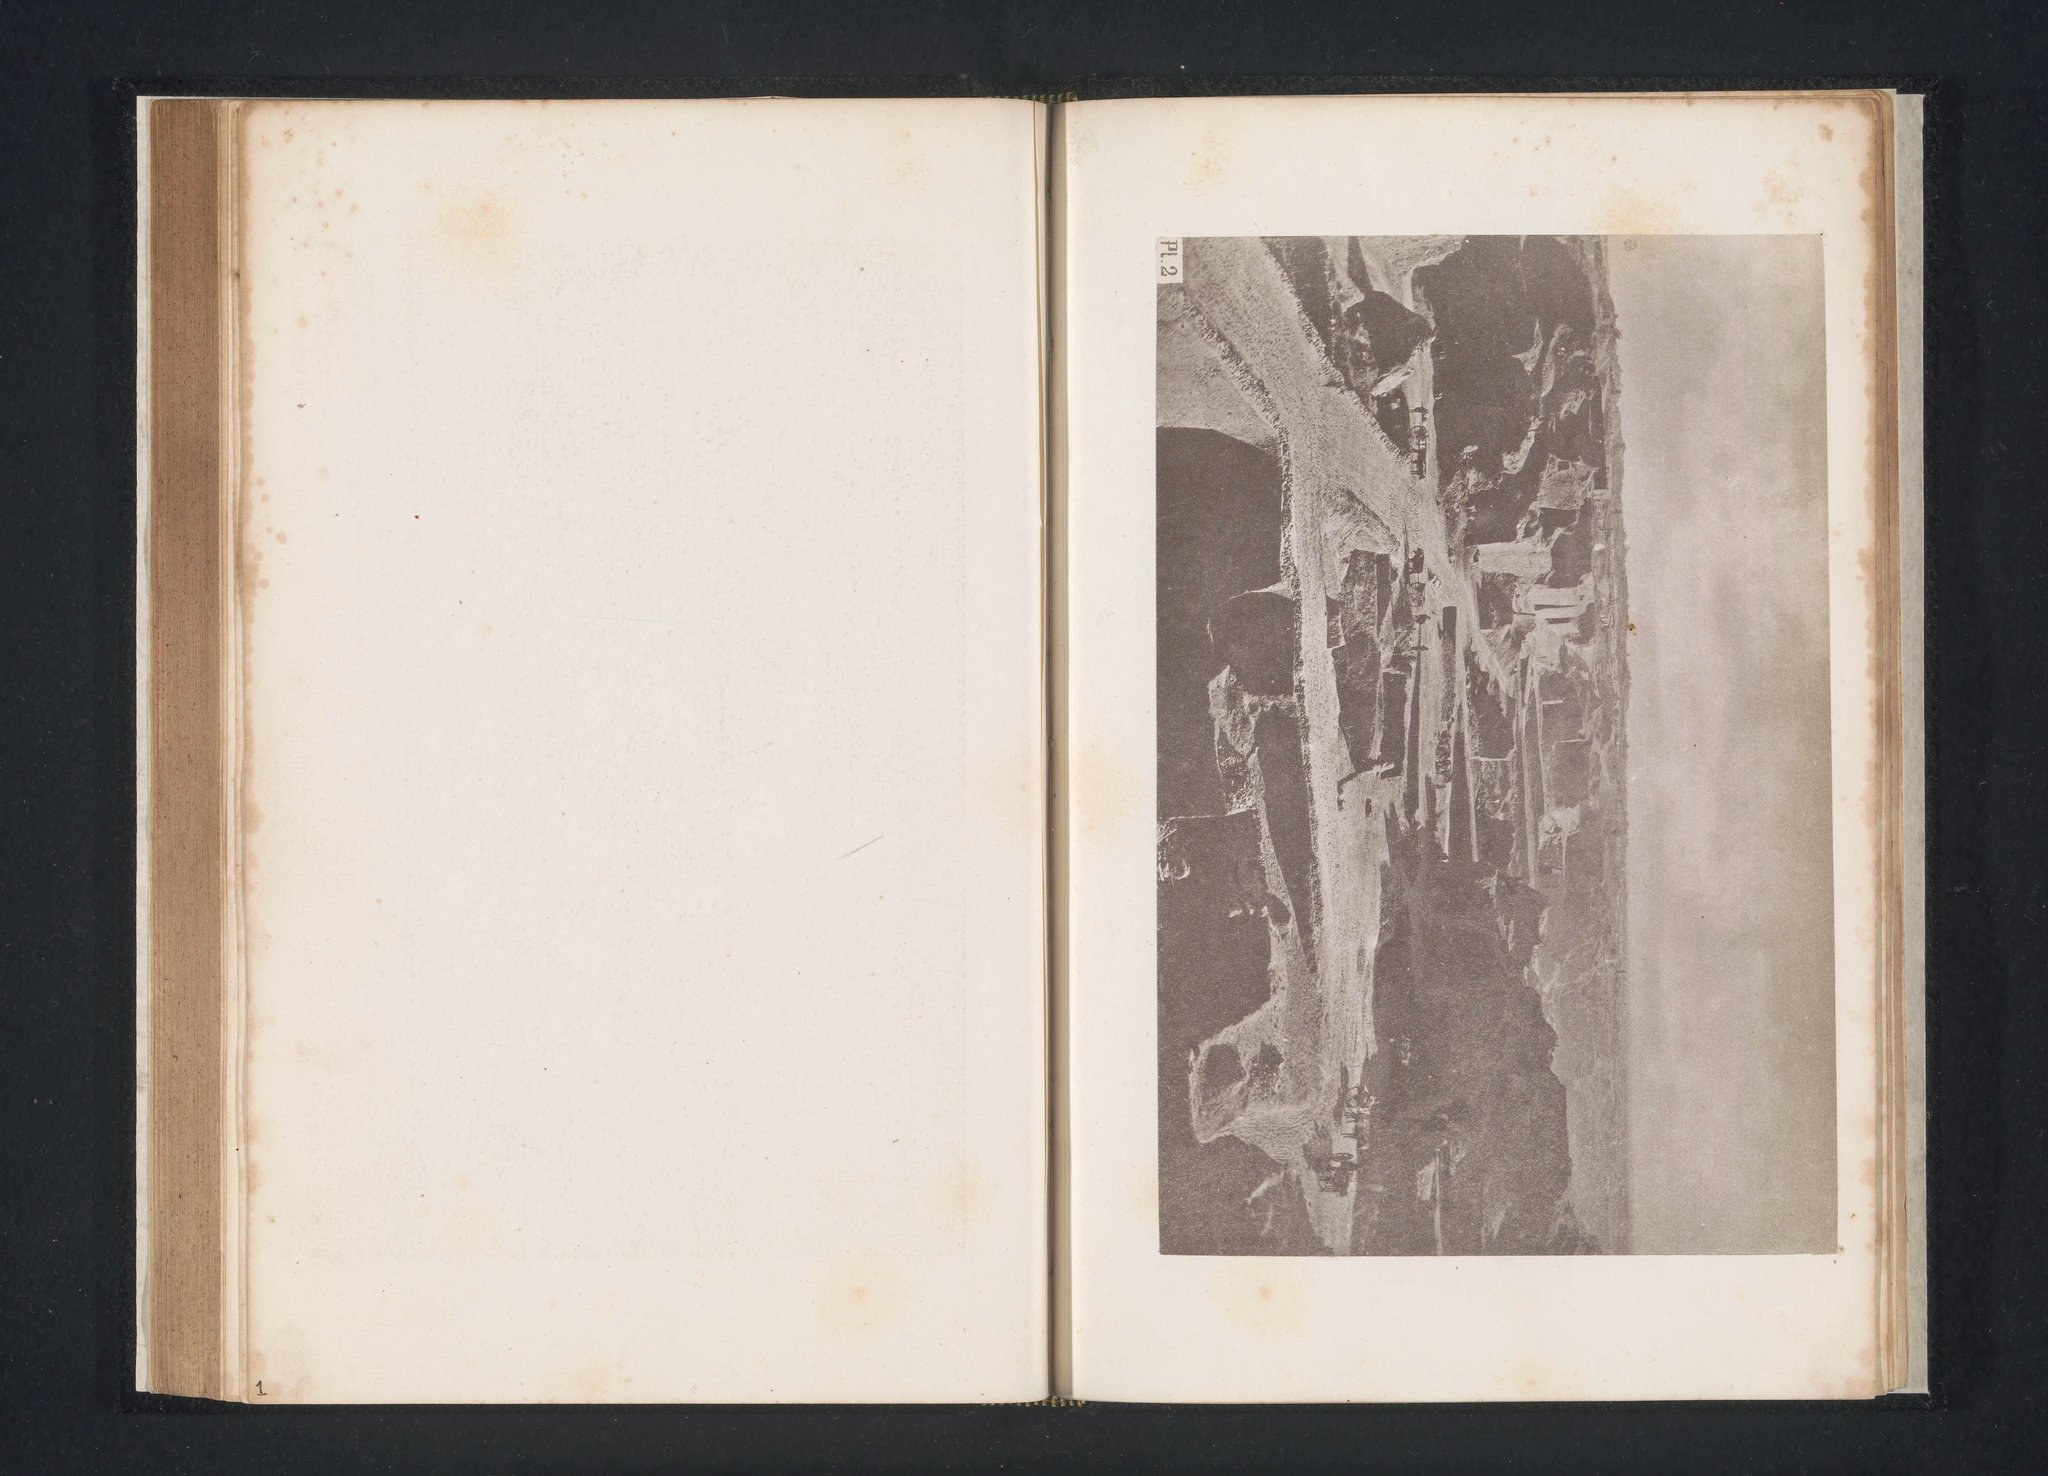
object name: photomechanical print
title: Gezicht op een diamantmijn in Zuid-Afrika, vermoedelijk bij Kimberley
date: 1870-1880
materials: paper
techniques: photograph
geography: south africa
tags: mine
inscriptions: number: ‘Pl. 2’